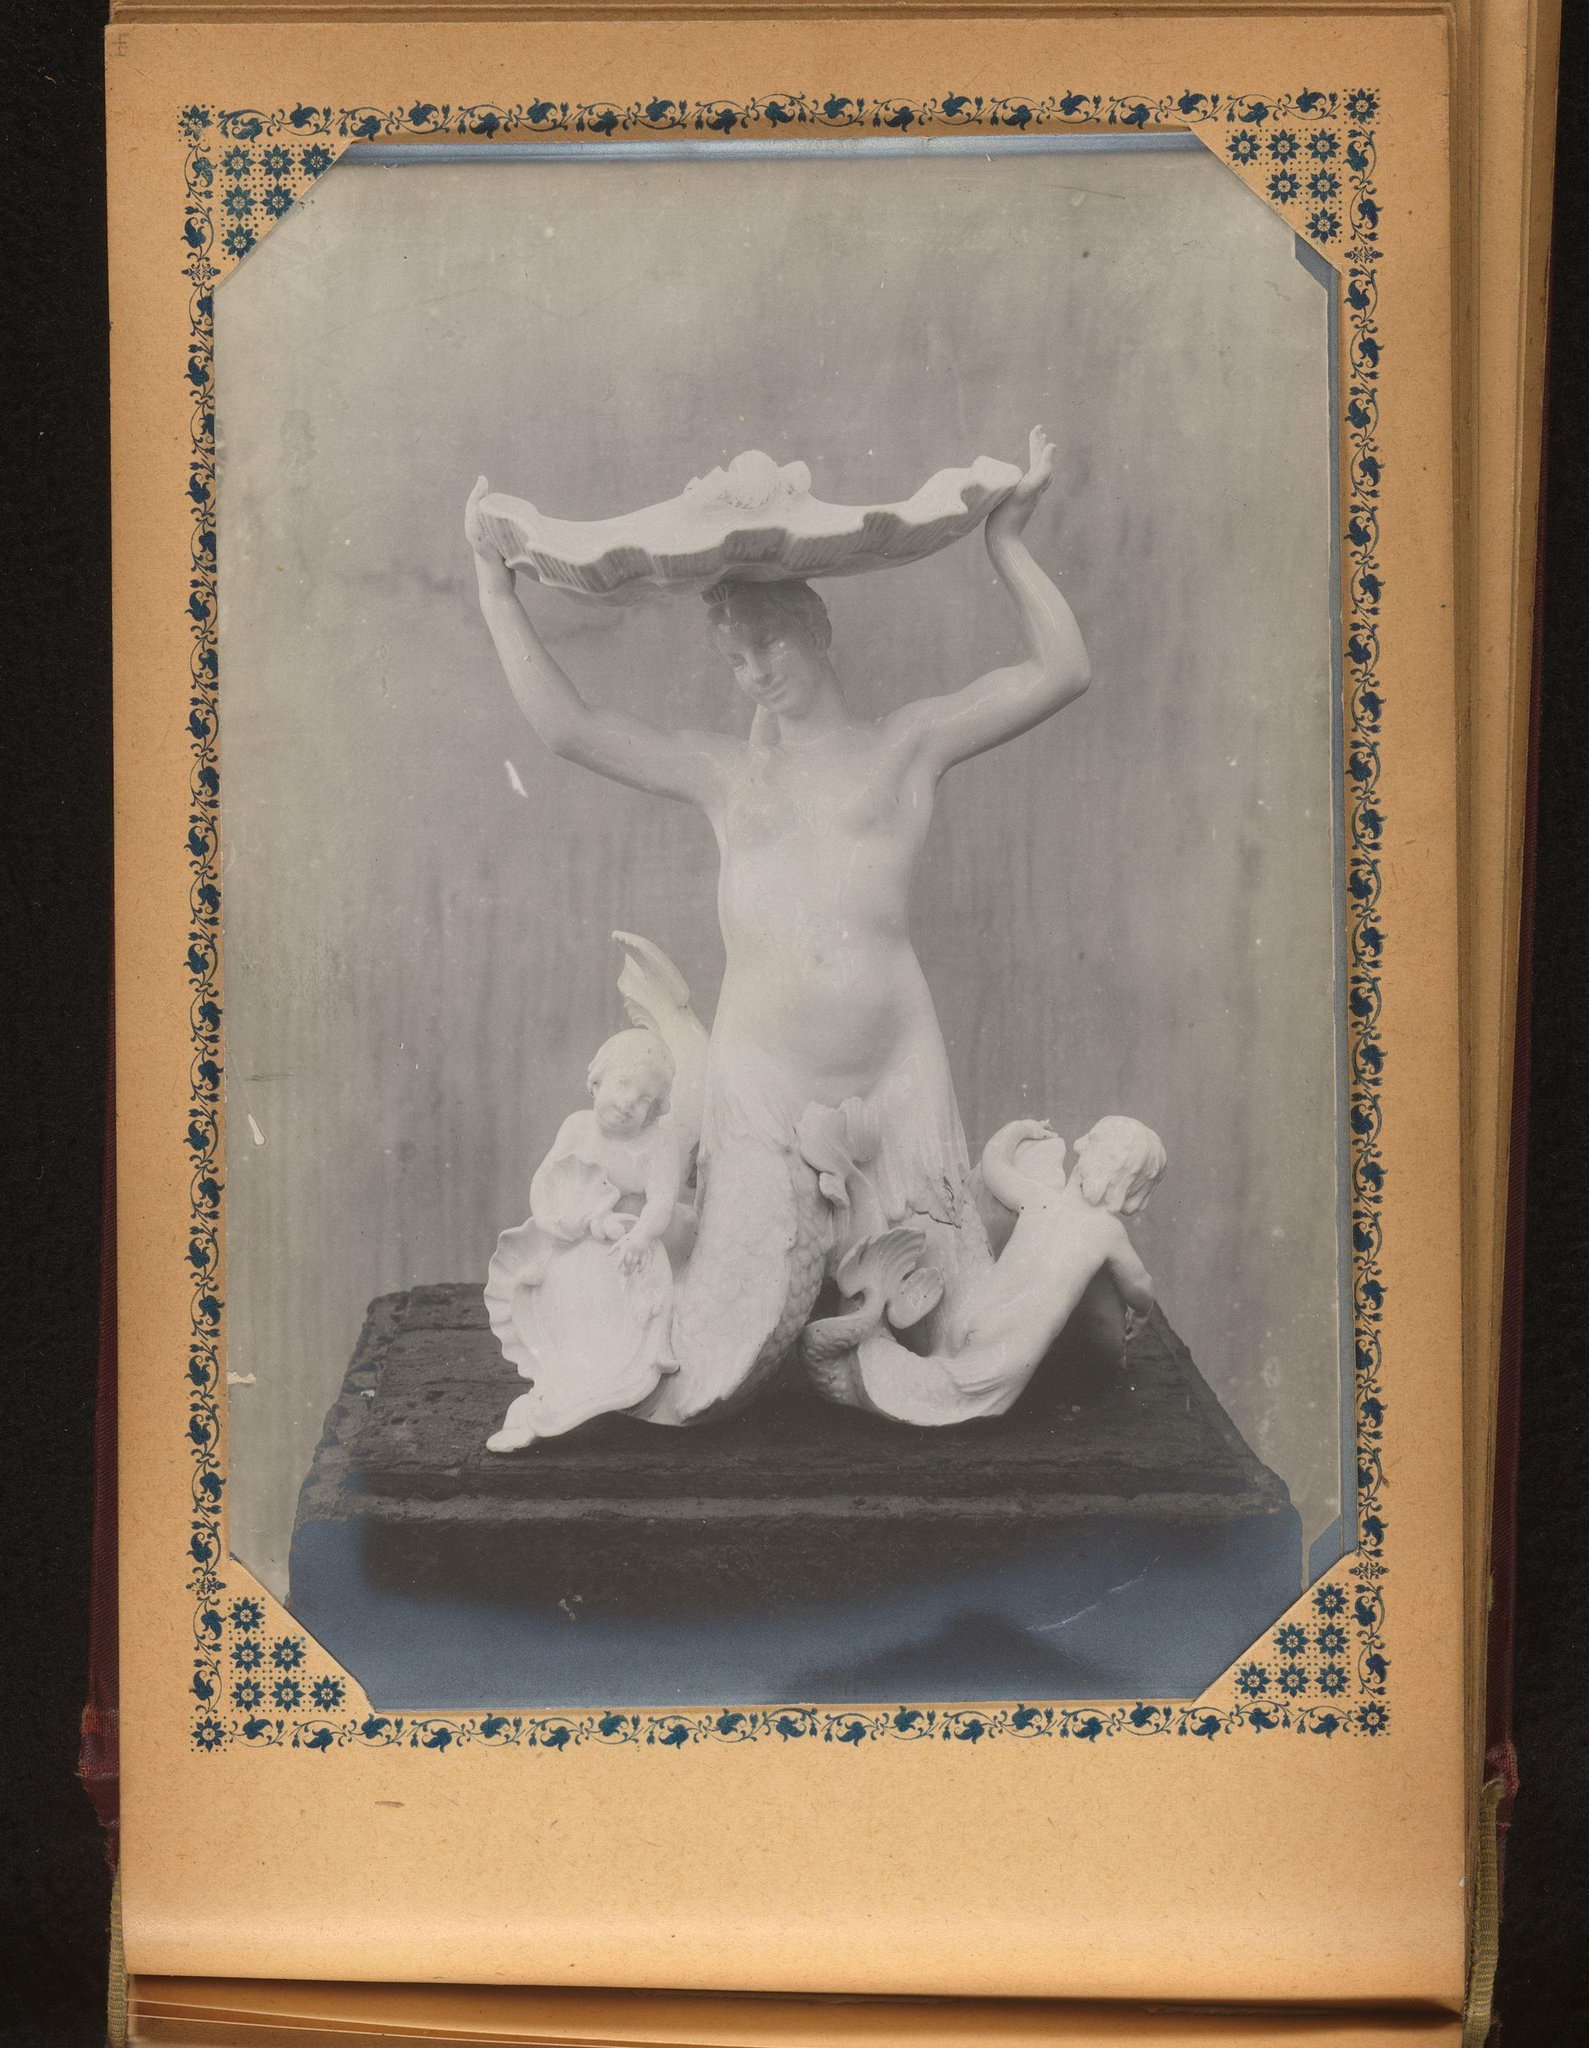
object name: album leaf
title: Sculptuur van een waternimf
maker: Anonymous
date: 1880-1940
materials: cardboard, photographic support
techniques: gelatin silver print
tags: nereids, daughters of nereus; sea-nymphs, piece of sculpture, reproduction of a piece of sculpture